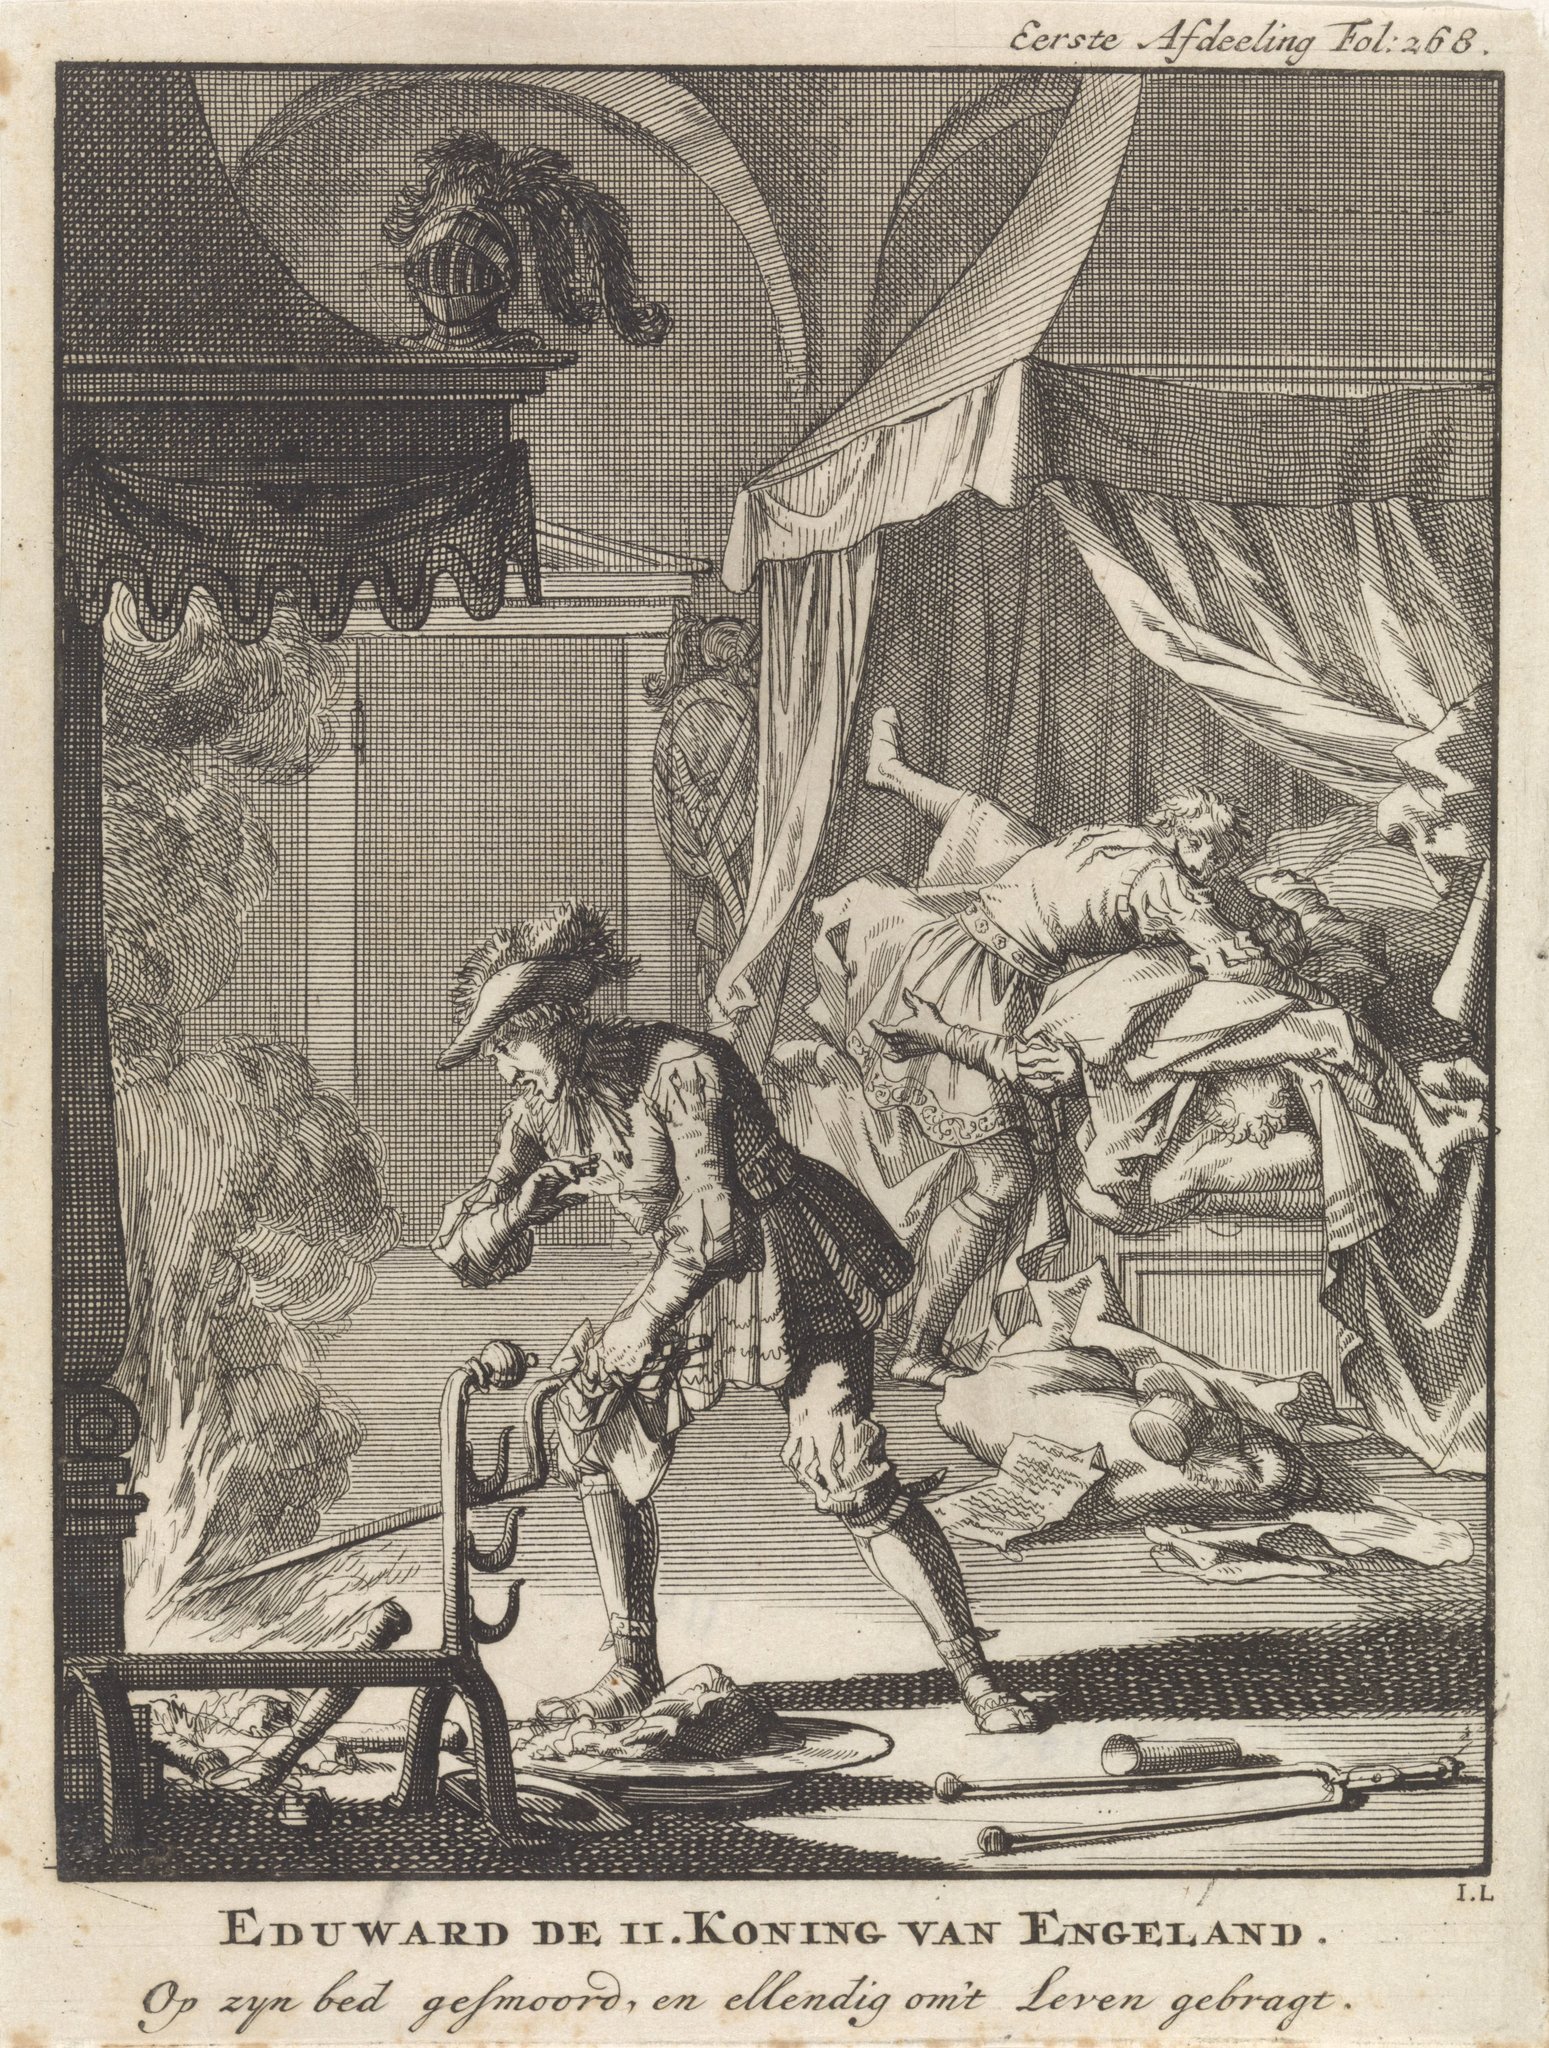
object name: print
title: Eduard II van Engeland vermoord in zijn slaapkamer, 1327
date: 1698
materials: paper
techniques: etching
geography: amsterdam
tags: attempt, political murder, bedroom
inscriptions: collector's mark: Lugt 2228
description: Illustratie uit: Bos, Lambert van den. Treur-toonneel der doorluchtige mannen, of Op- en ondergang der grooten, 3 delen. Amsterdam: Jan Claesz ten Hoorn, 1698, dl. I.